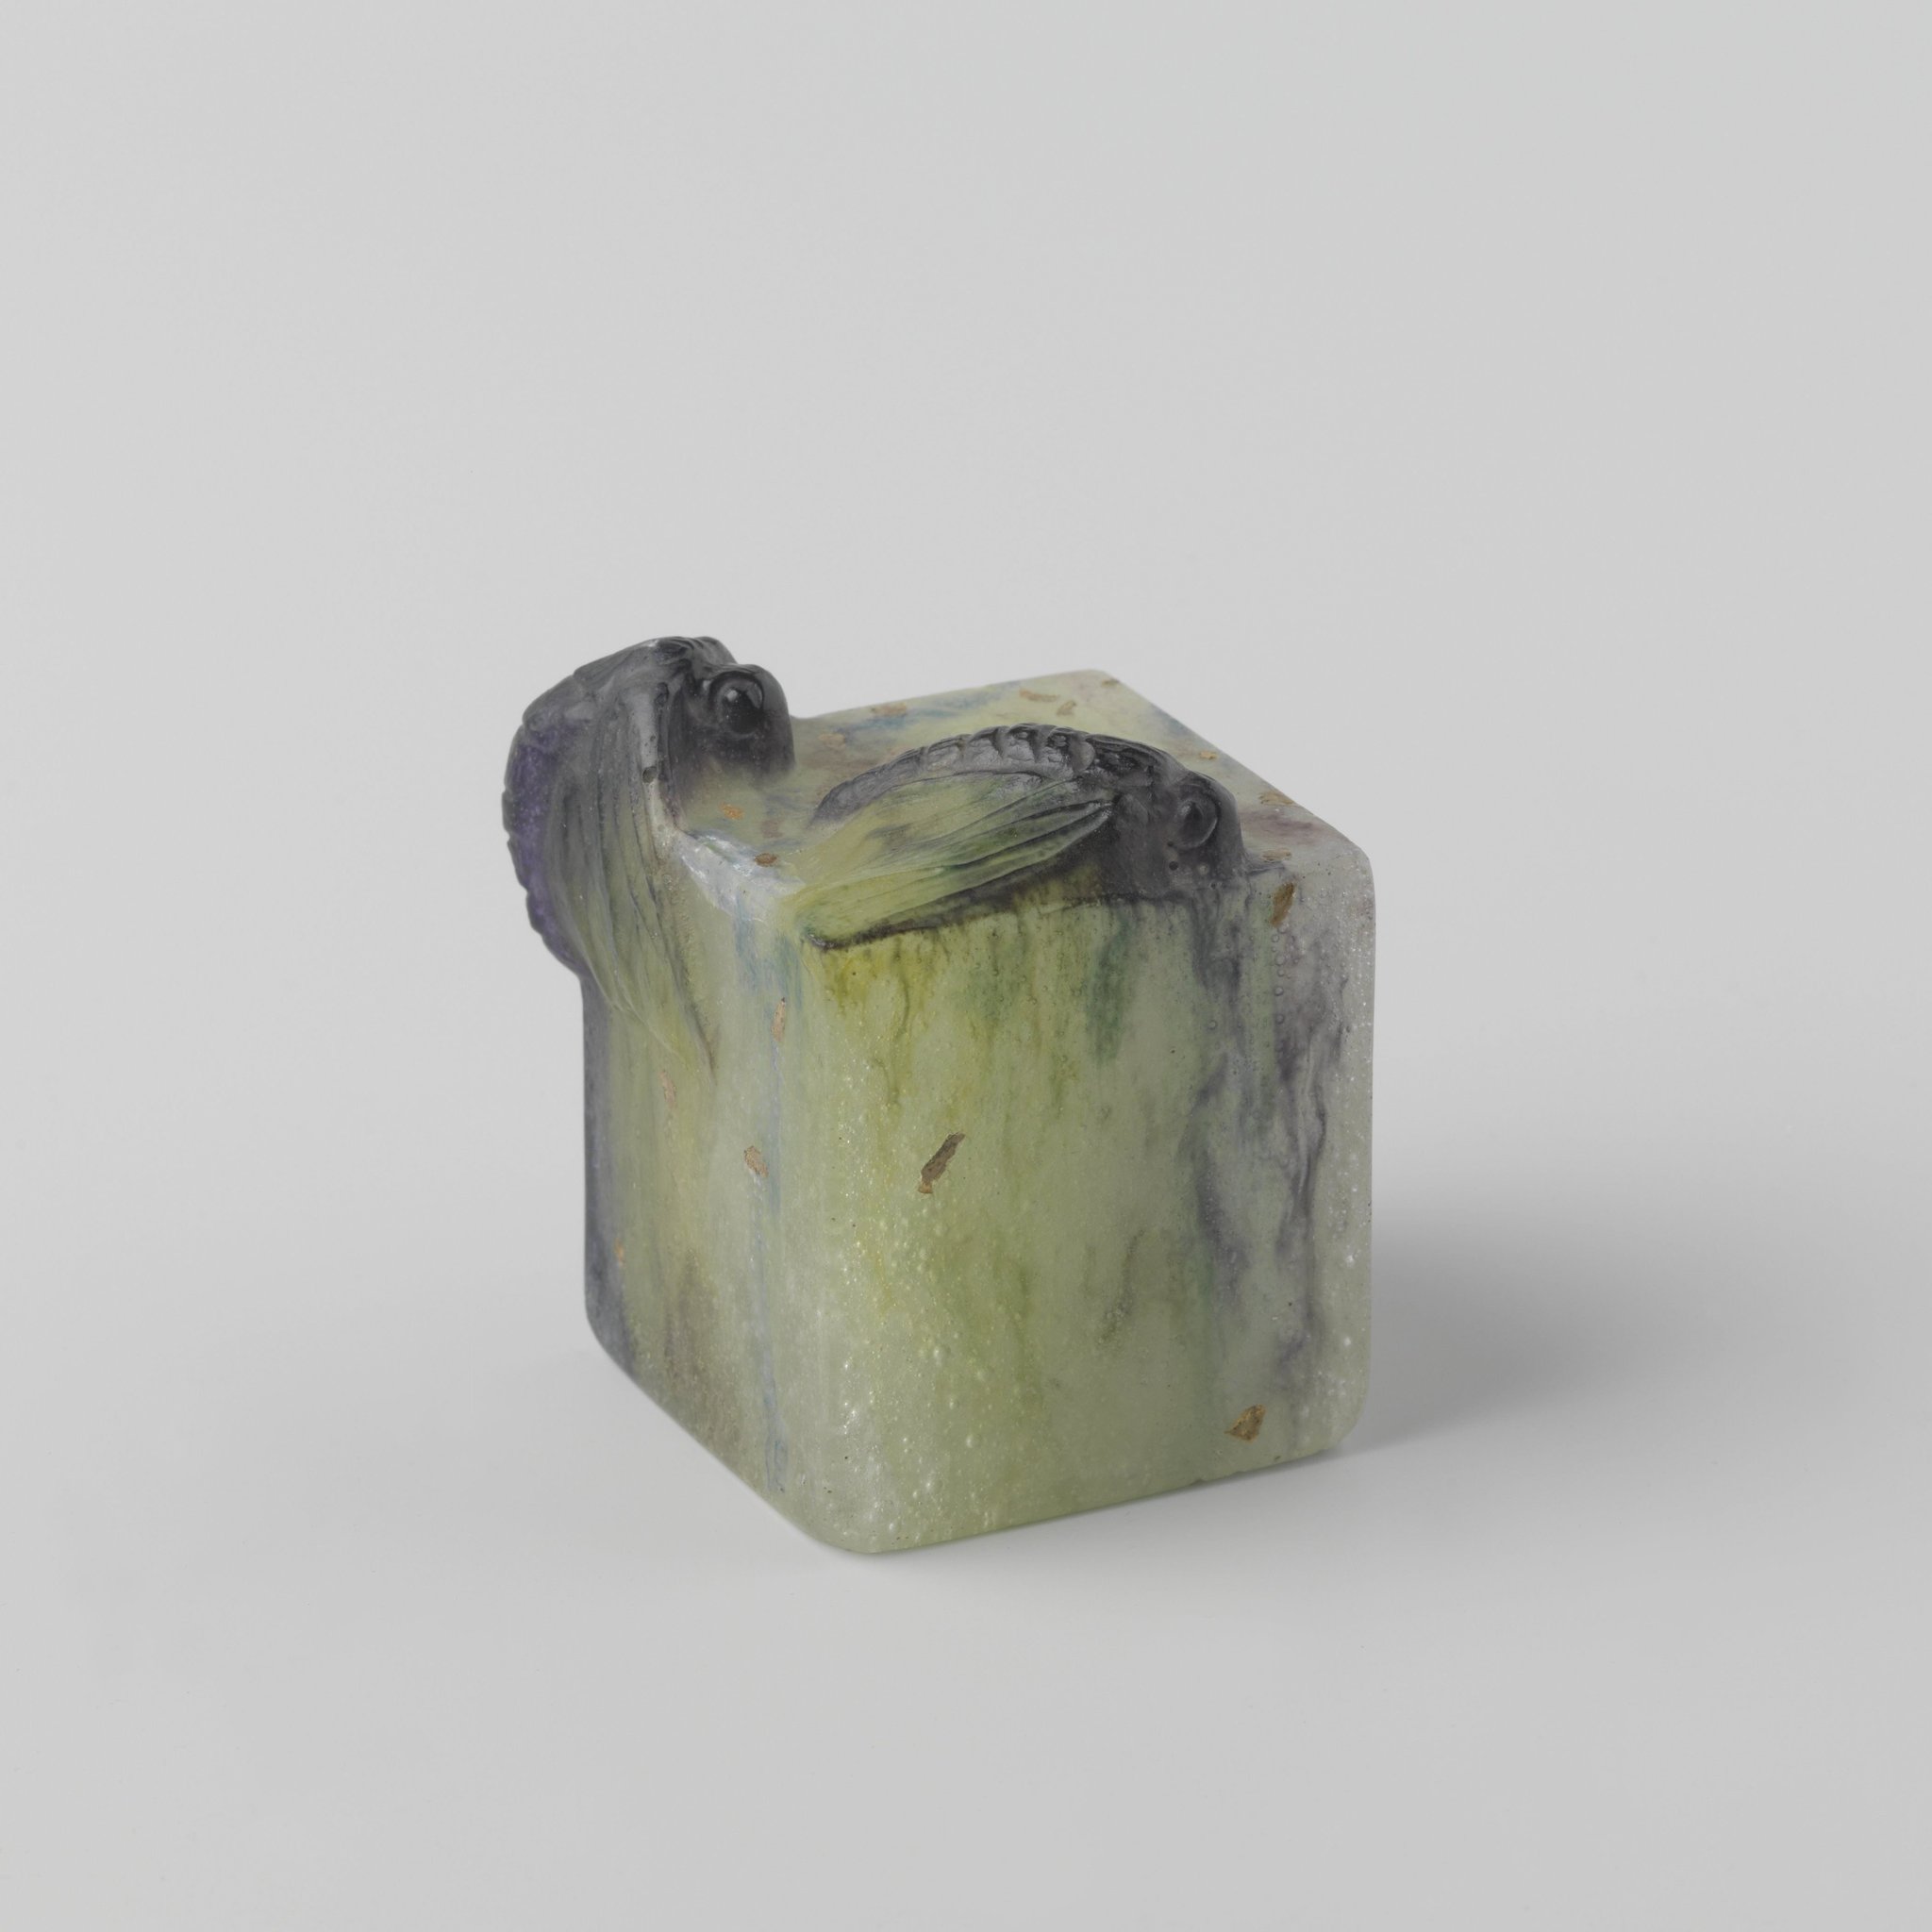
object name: paperweight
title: Presse-papier 'Papillon de nuit'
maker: gabriel argy-rousseau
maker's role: ceramicist, designer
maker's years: 1885-1953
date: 1928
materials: glass, gold leaf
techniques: glassblowing, pâte de verre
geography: paris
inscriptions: signature: ‘G.Argy Rousseau.’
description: Presse-papier. Papillon de nuit. Glass. Paris, 1928, by Gabriel Argy-Rousseau.